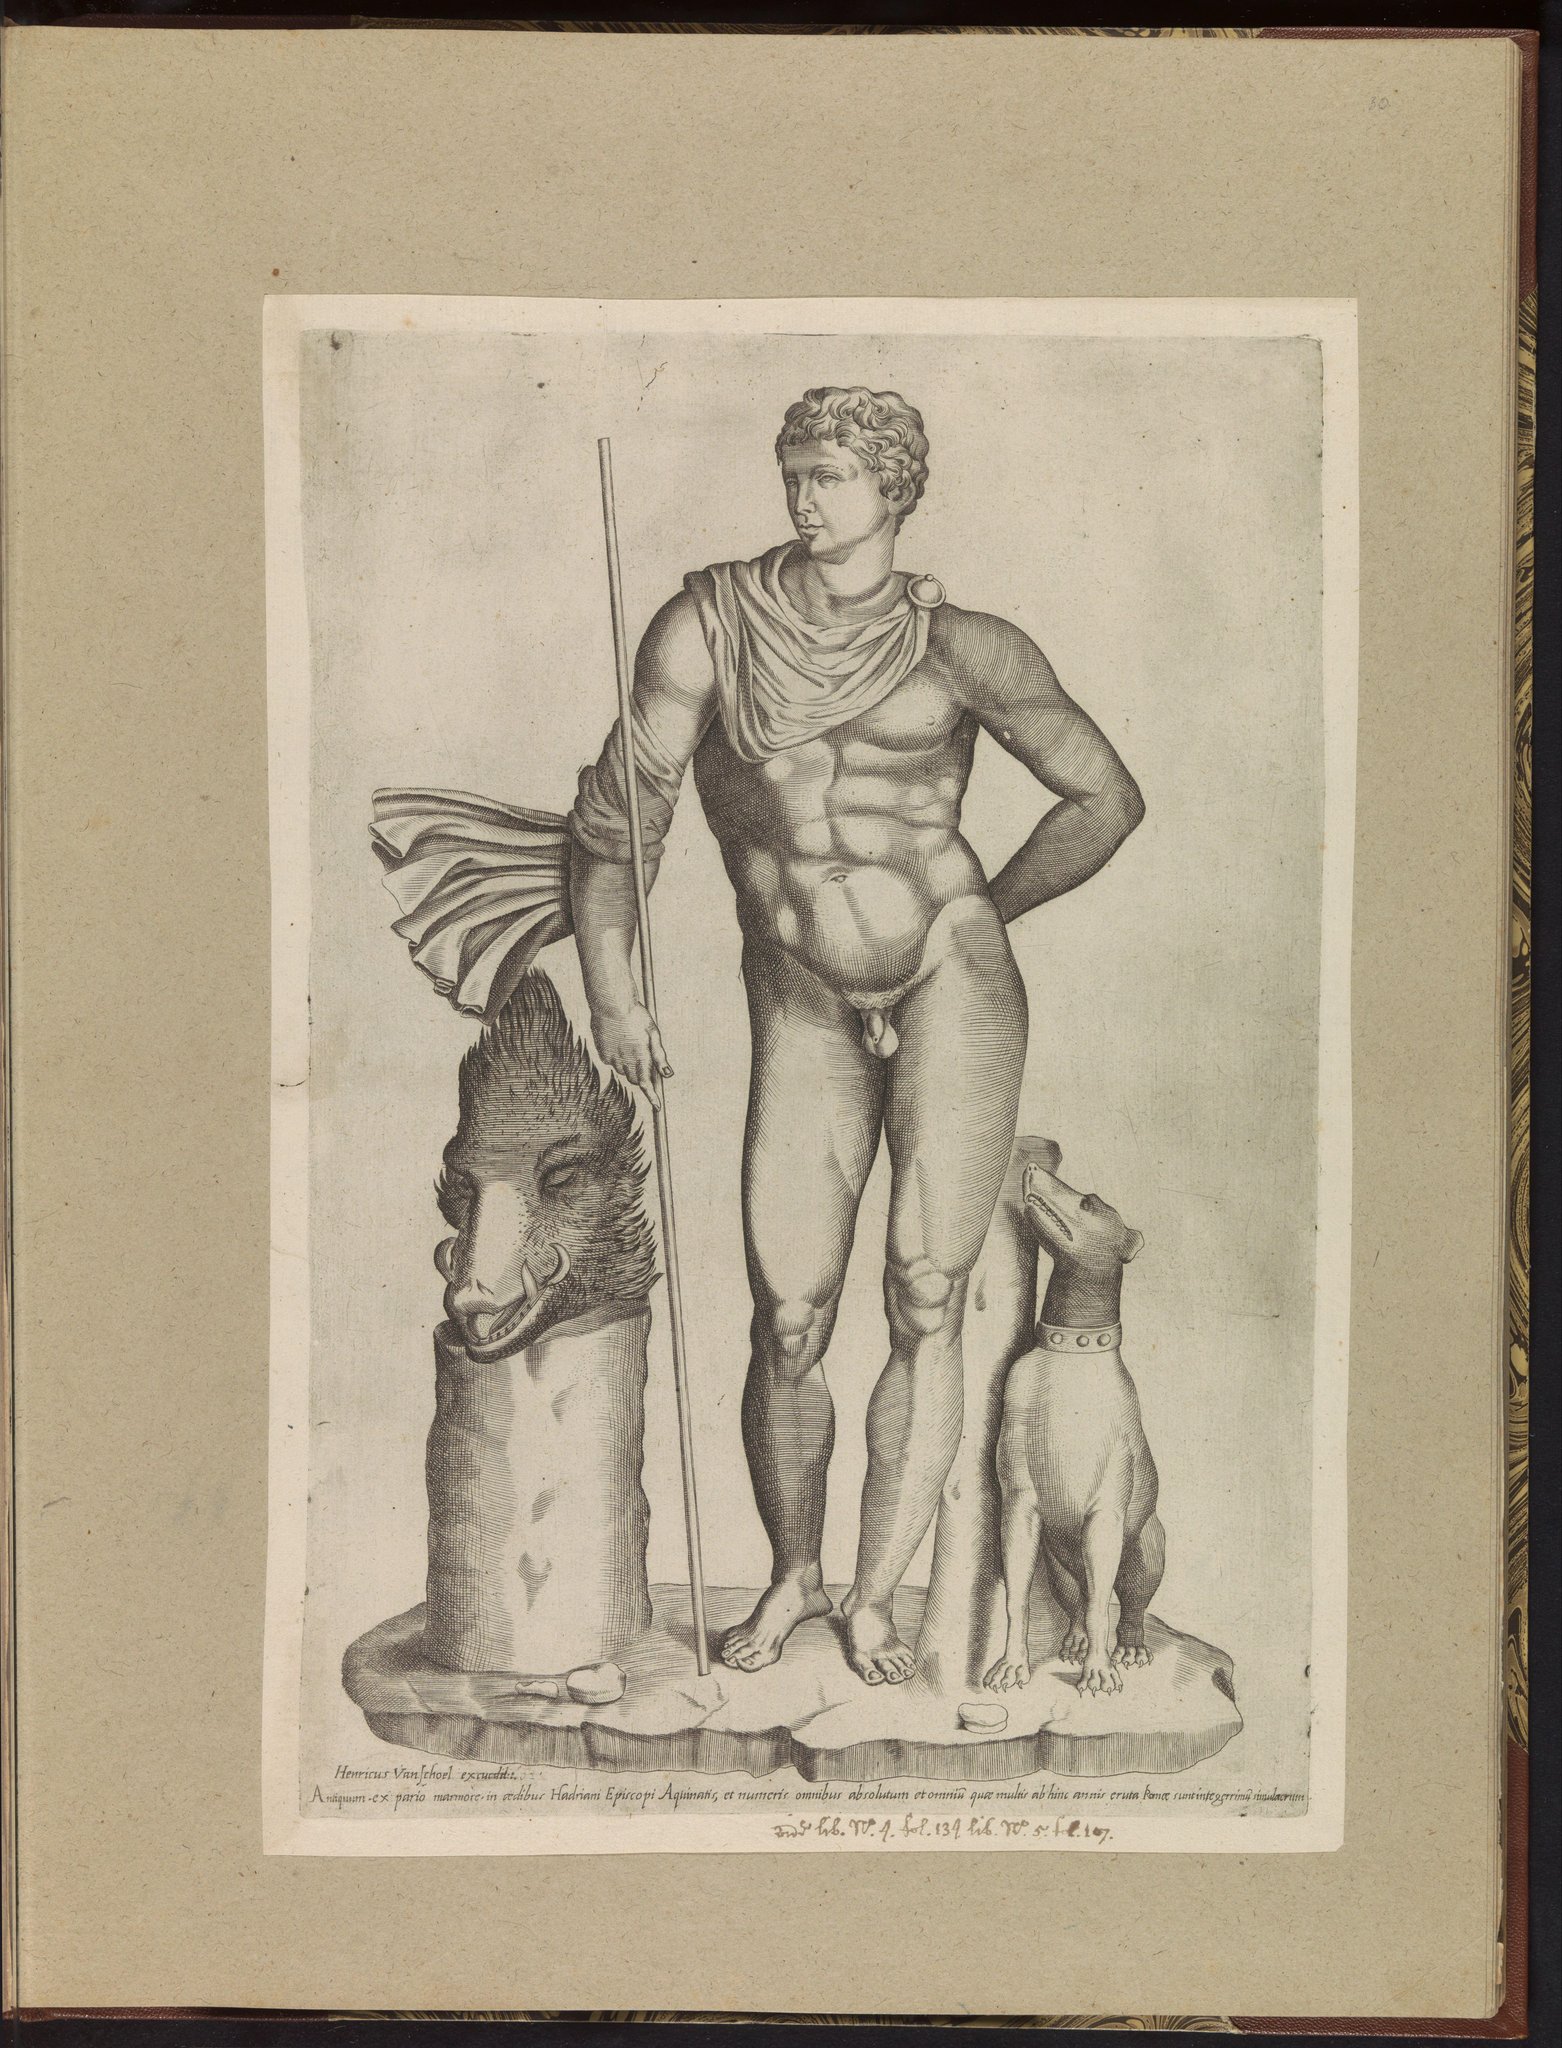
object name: print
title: Antiquum ex pario marmore in aedibus Hadriani Epsicopi Aquinatis, et numeris omnibus absolutum et omniu quae muleis ab hinc annis eruta Romae suntinte gerrimu simulacrum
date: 1595-1622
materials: paper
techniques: etching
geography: italy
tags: piece of sculpture, reproduction of a piece of sculpture, (story of) meleager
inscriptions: inscription: ‘Ende lib. No. 4. fol. 134 lib. No. 5. fol. 107.’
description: Een sculptuur van Meleager met een hond, een speer en de kop van het Calydonische everzwijn. De prent maakt deel uit van een album.